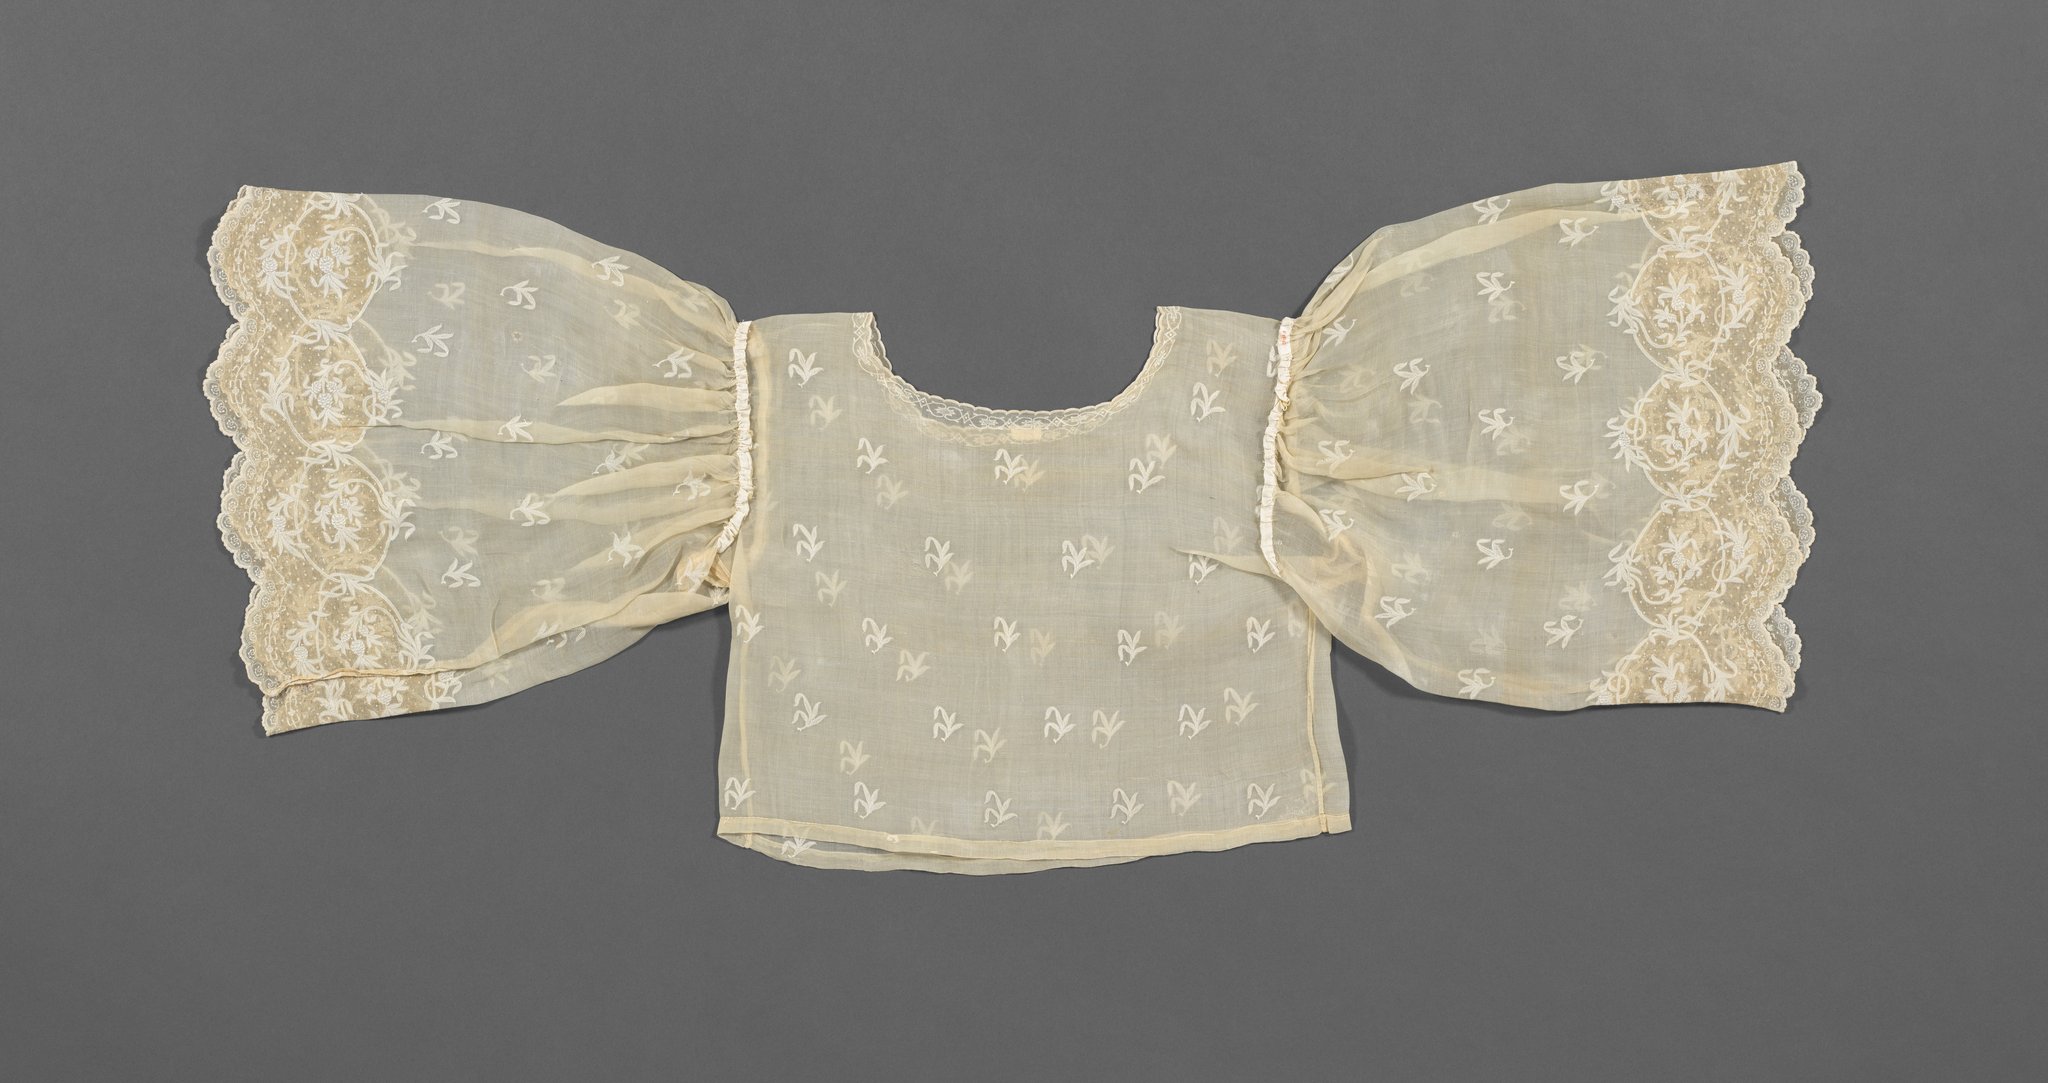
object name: blouse and sleeve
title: Blouse (Camisa) and sleeves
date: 1801-1850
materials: fiber, linen